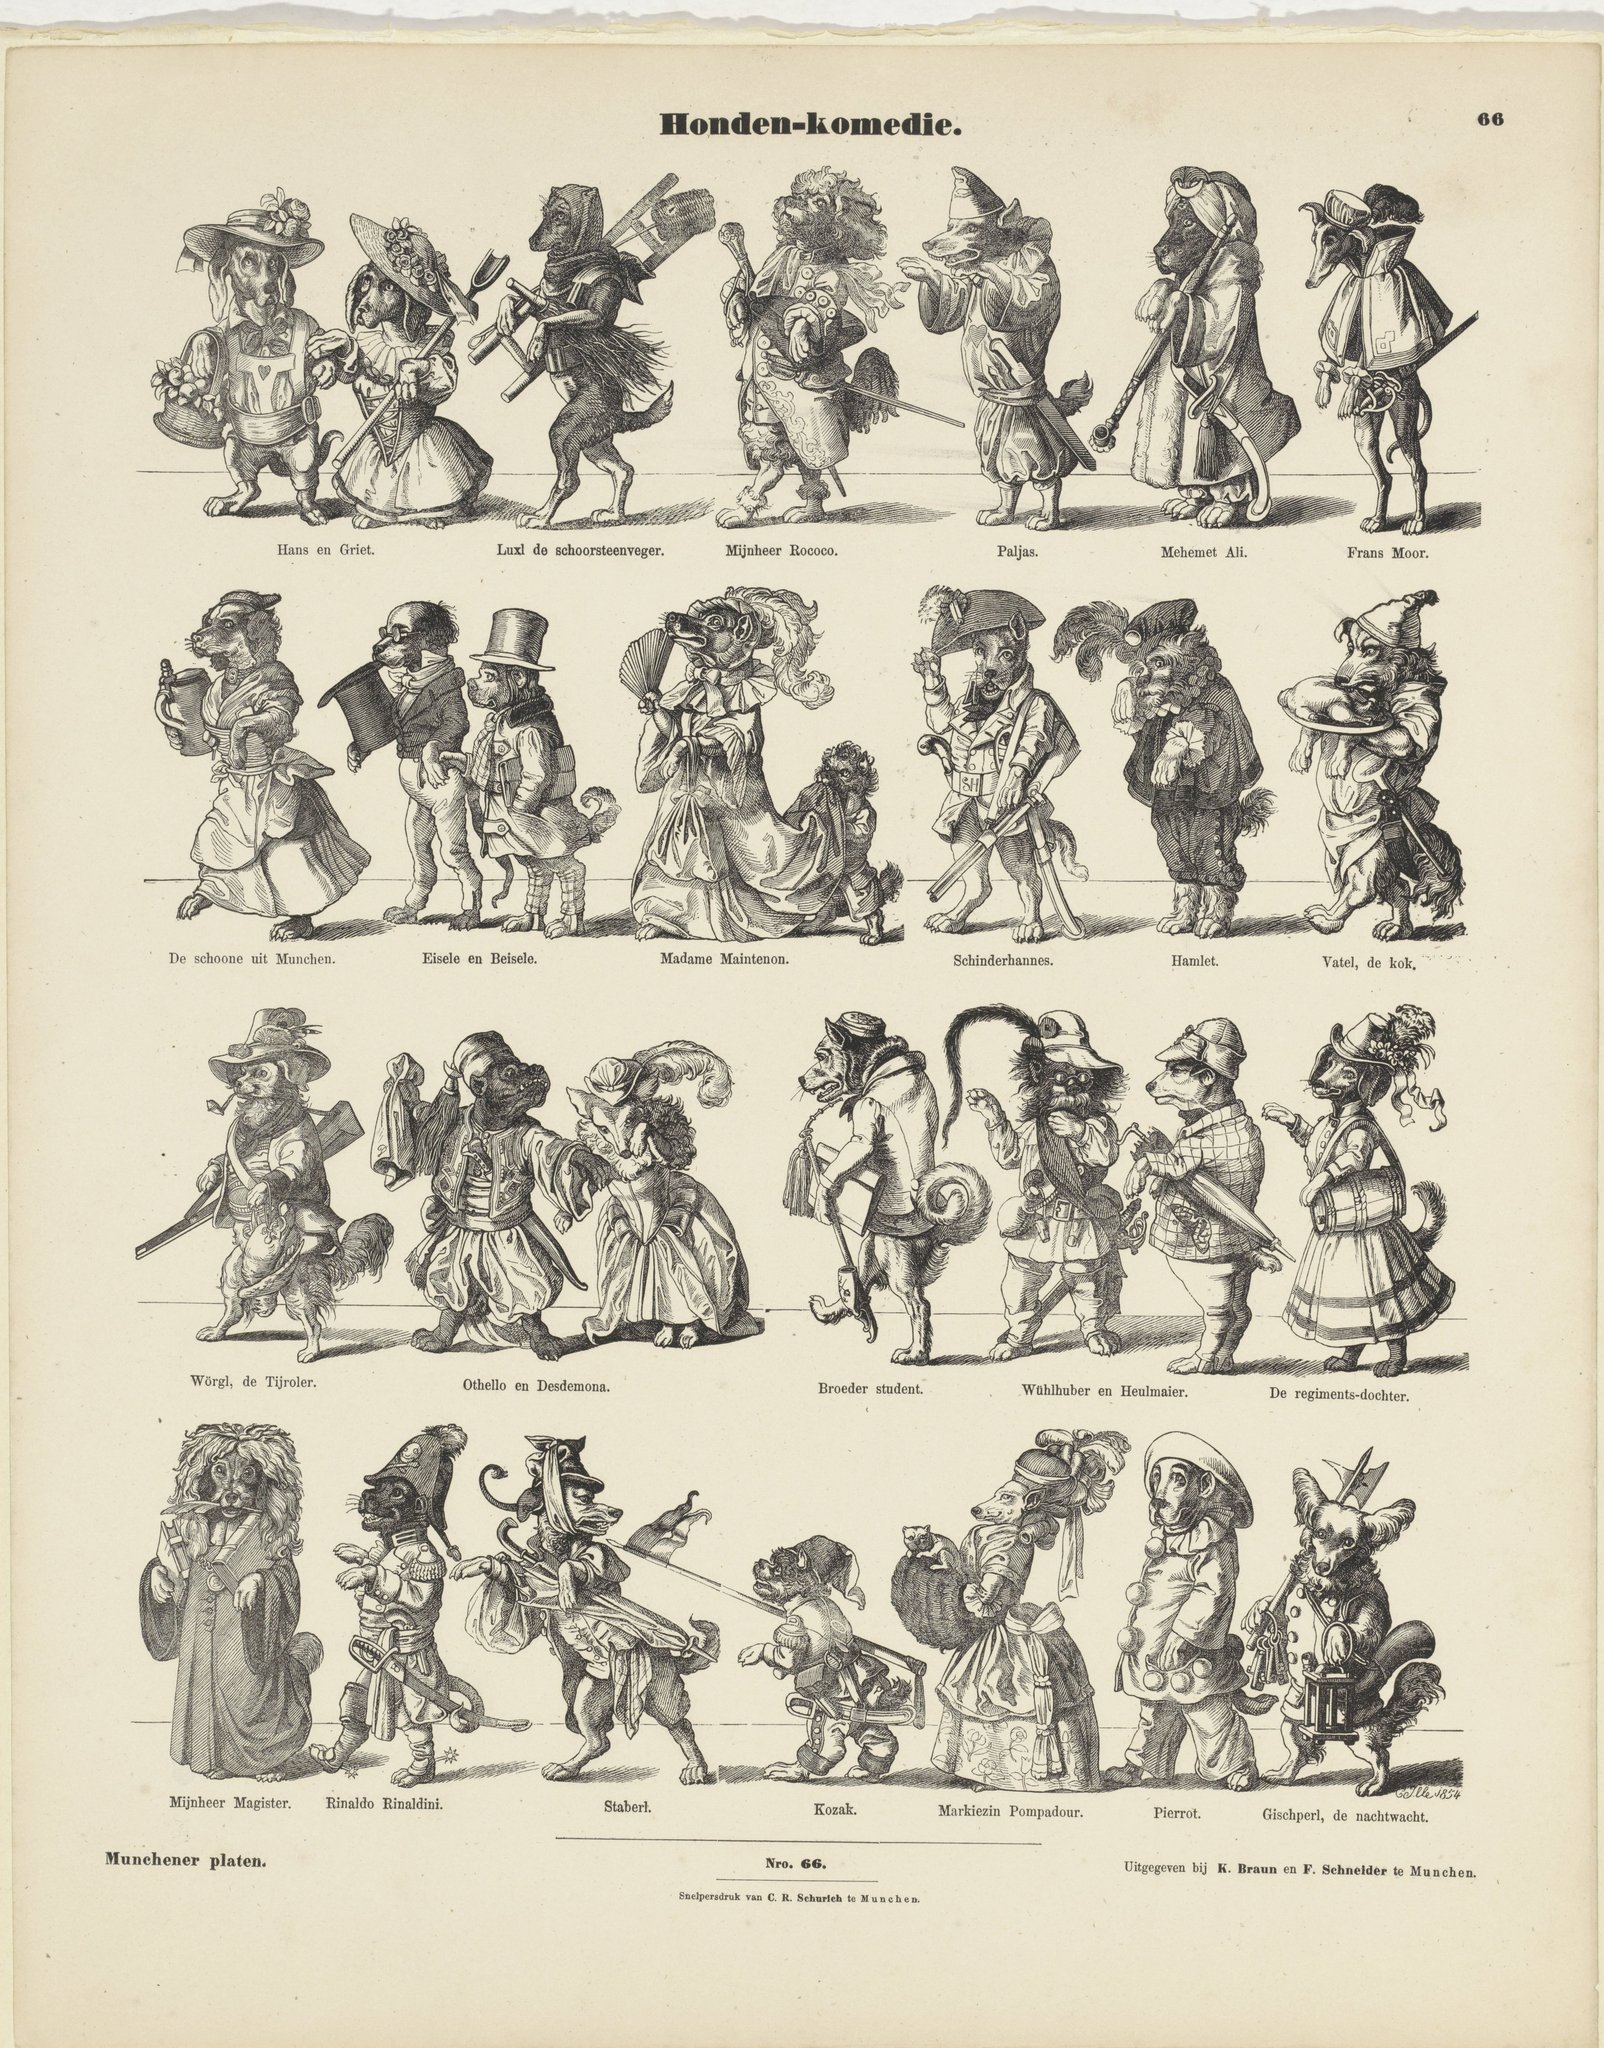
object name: popular print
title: Honden-komedie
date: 1854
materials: paper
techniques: letterpress printing, engraving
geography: germany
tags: animals acting as human beings, actor (on the stage), dog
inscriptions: collector's mark: Lugt 2760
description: Blad met 4 horizontale rijen met honden verkleed als theaterfiguren. Onder elke hond de naam van het personage. Genummerd midden onder: Nro. 66. Genummerd rechtsboven: 66.